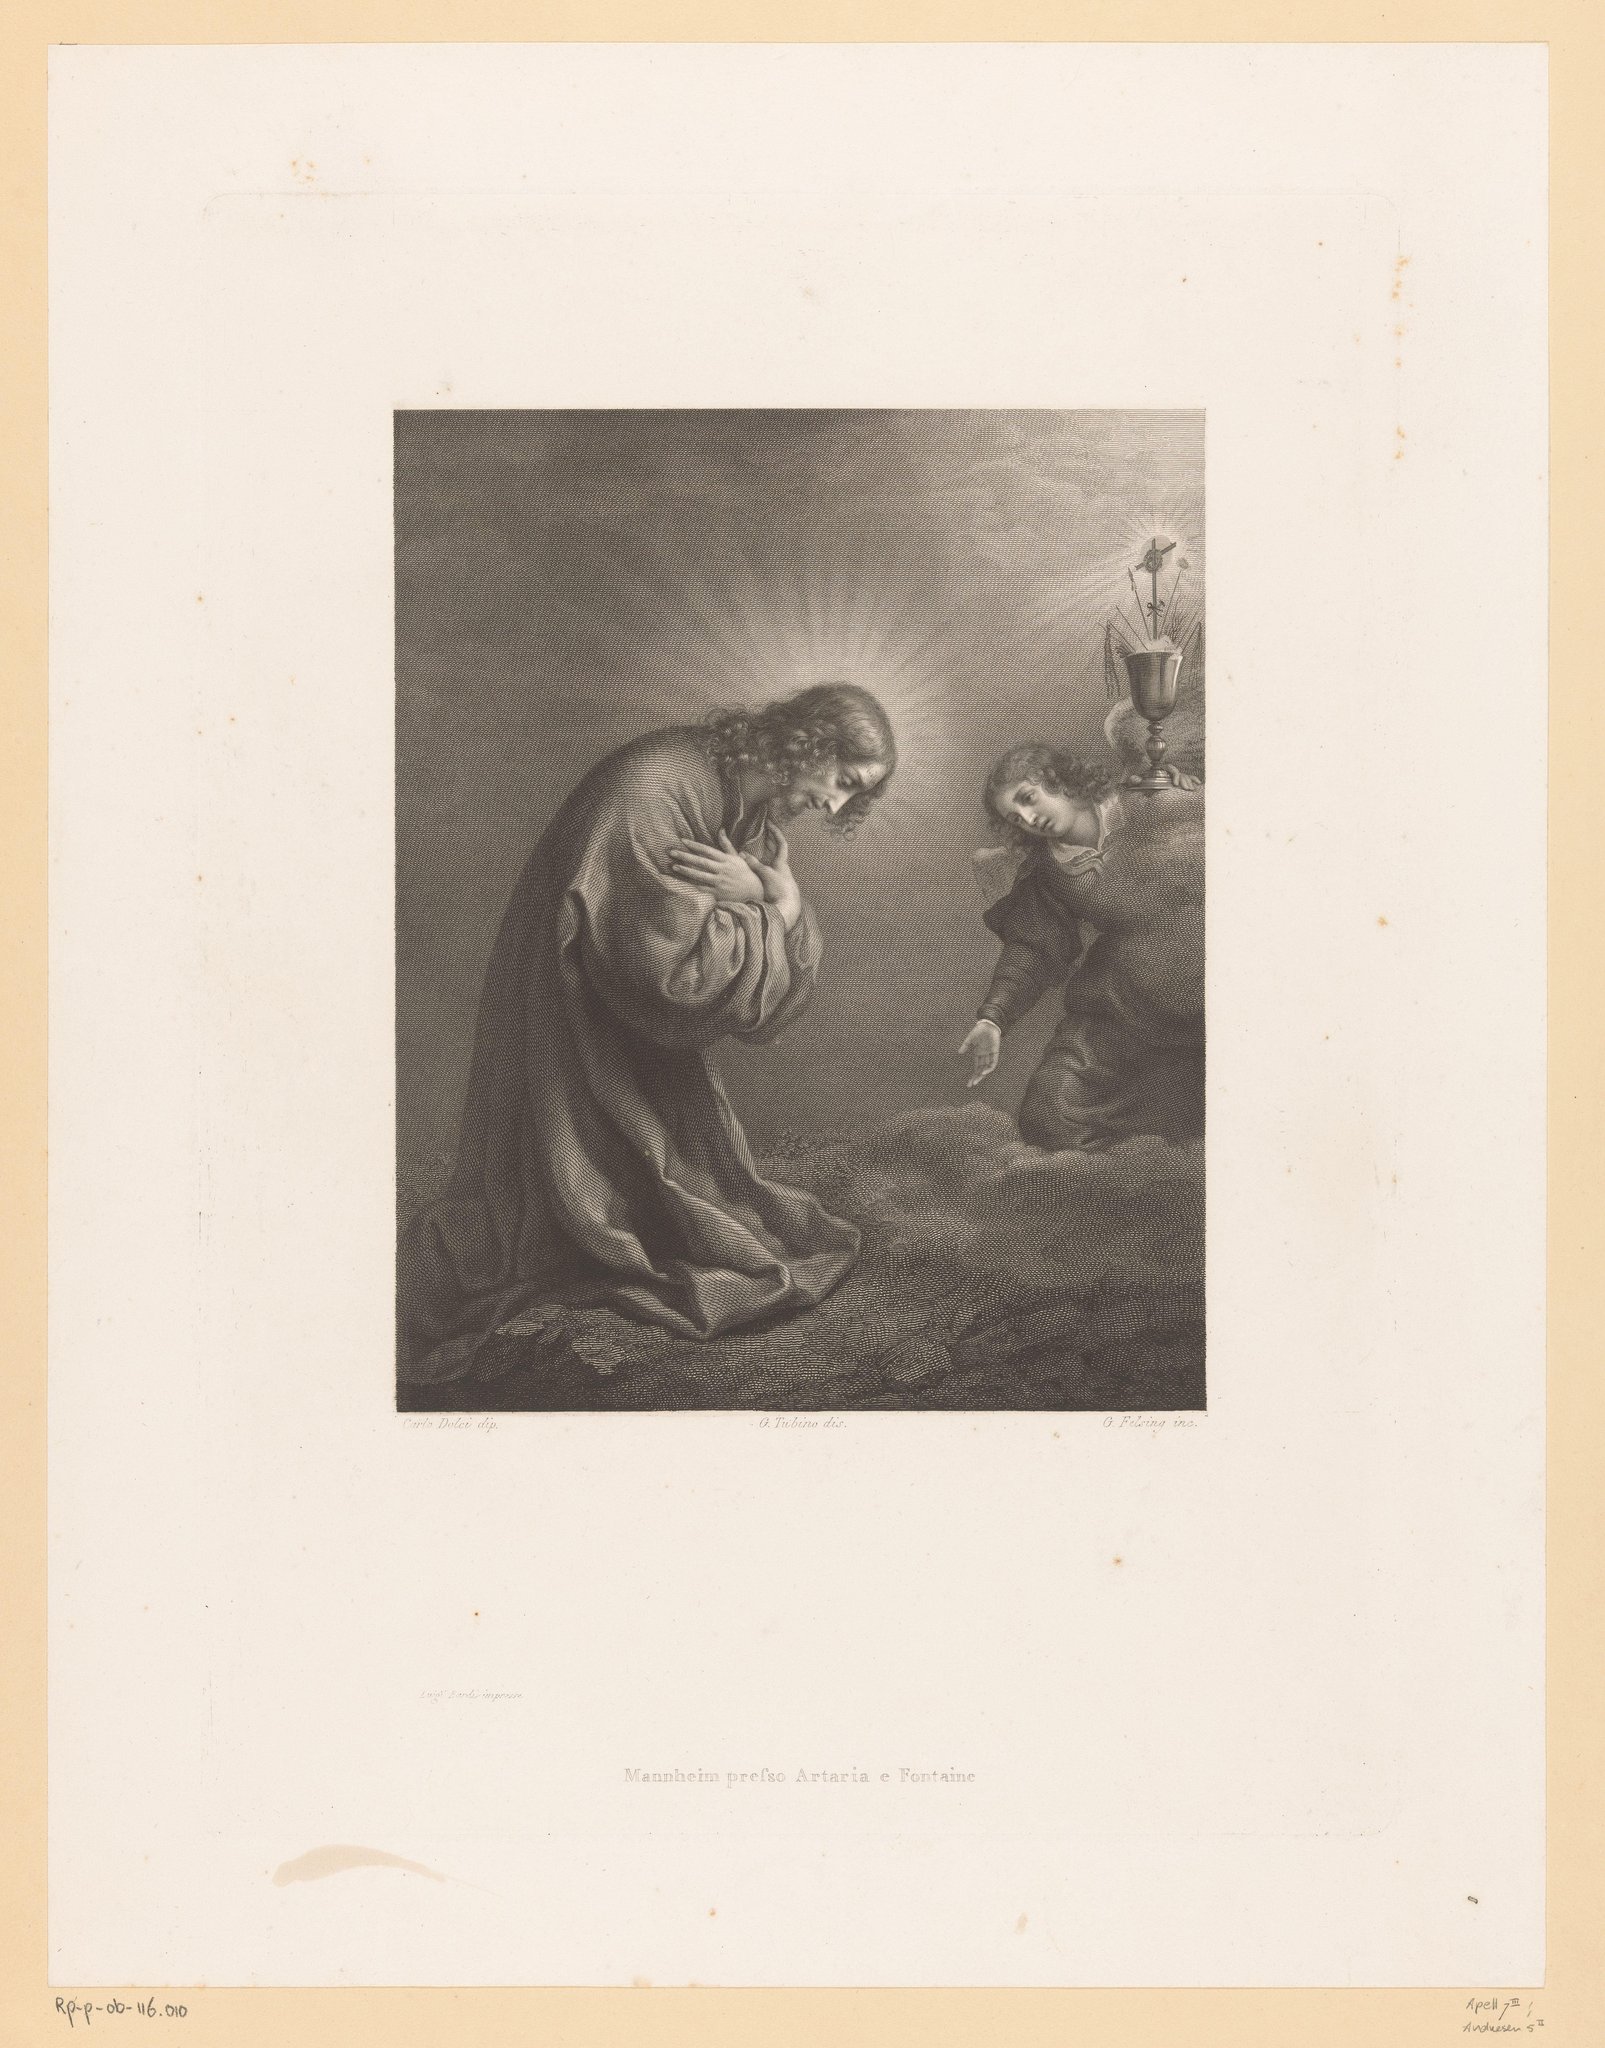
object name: print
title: Christus in de hof van Getsemane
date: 1828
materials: paper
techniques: engraving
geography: mannheim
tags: christ's prayer in the garden of gethsemane during the night, 'arma christi', chalice, angels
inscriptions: collector's mark: Lugt 12